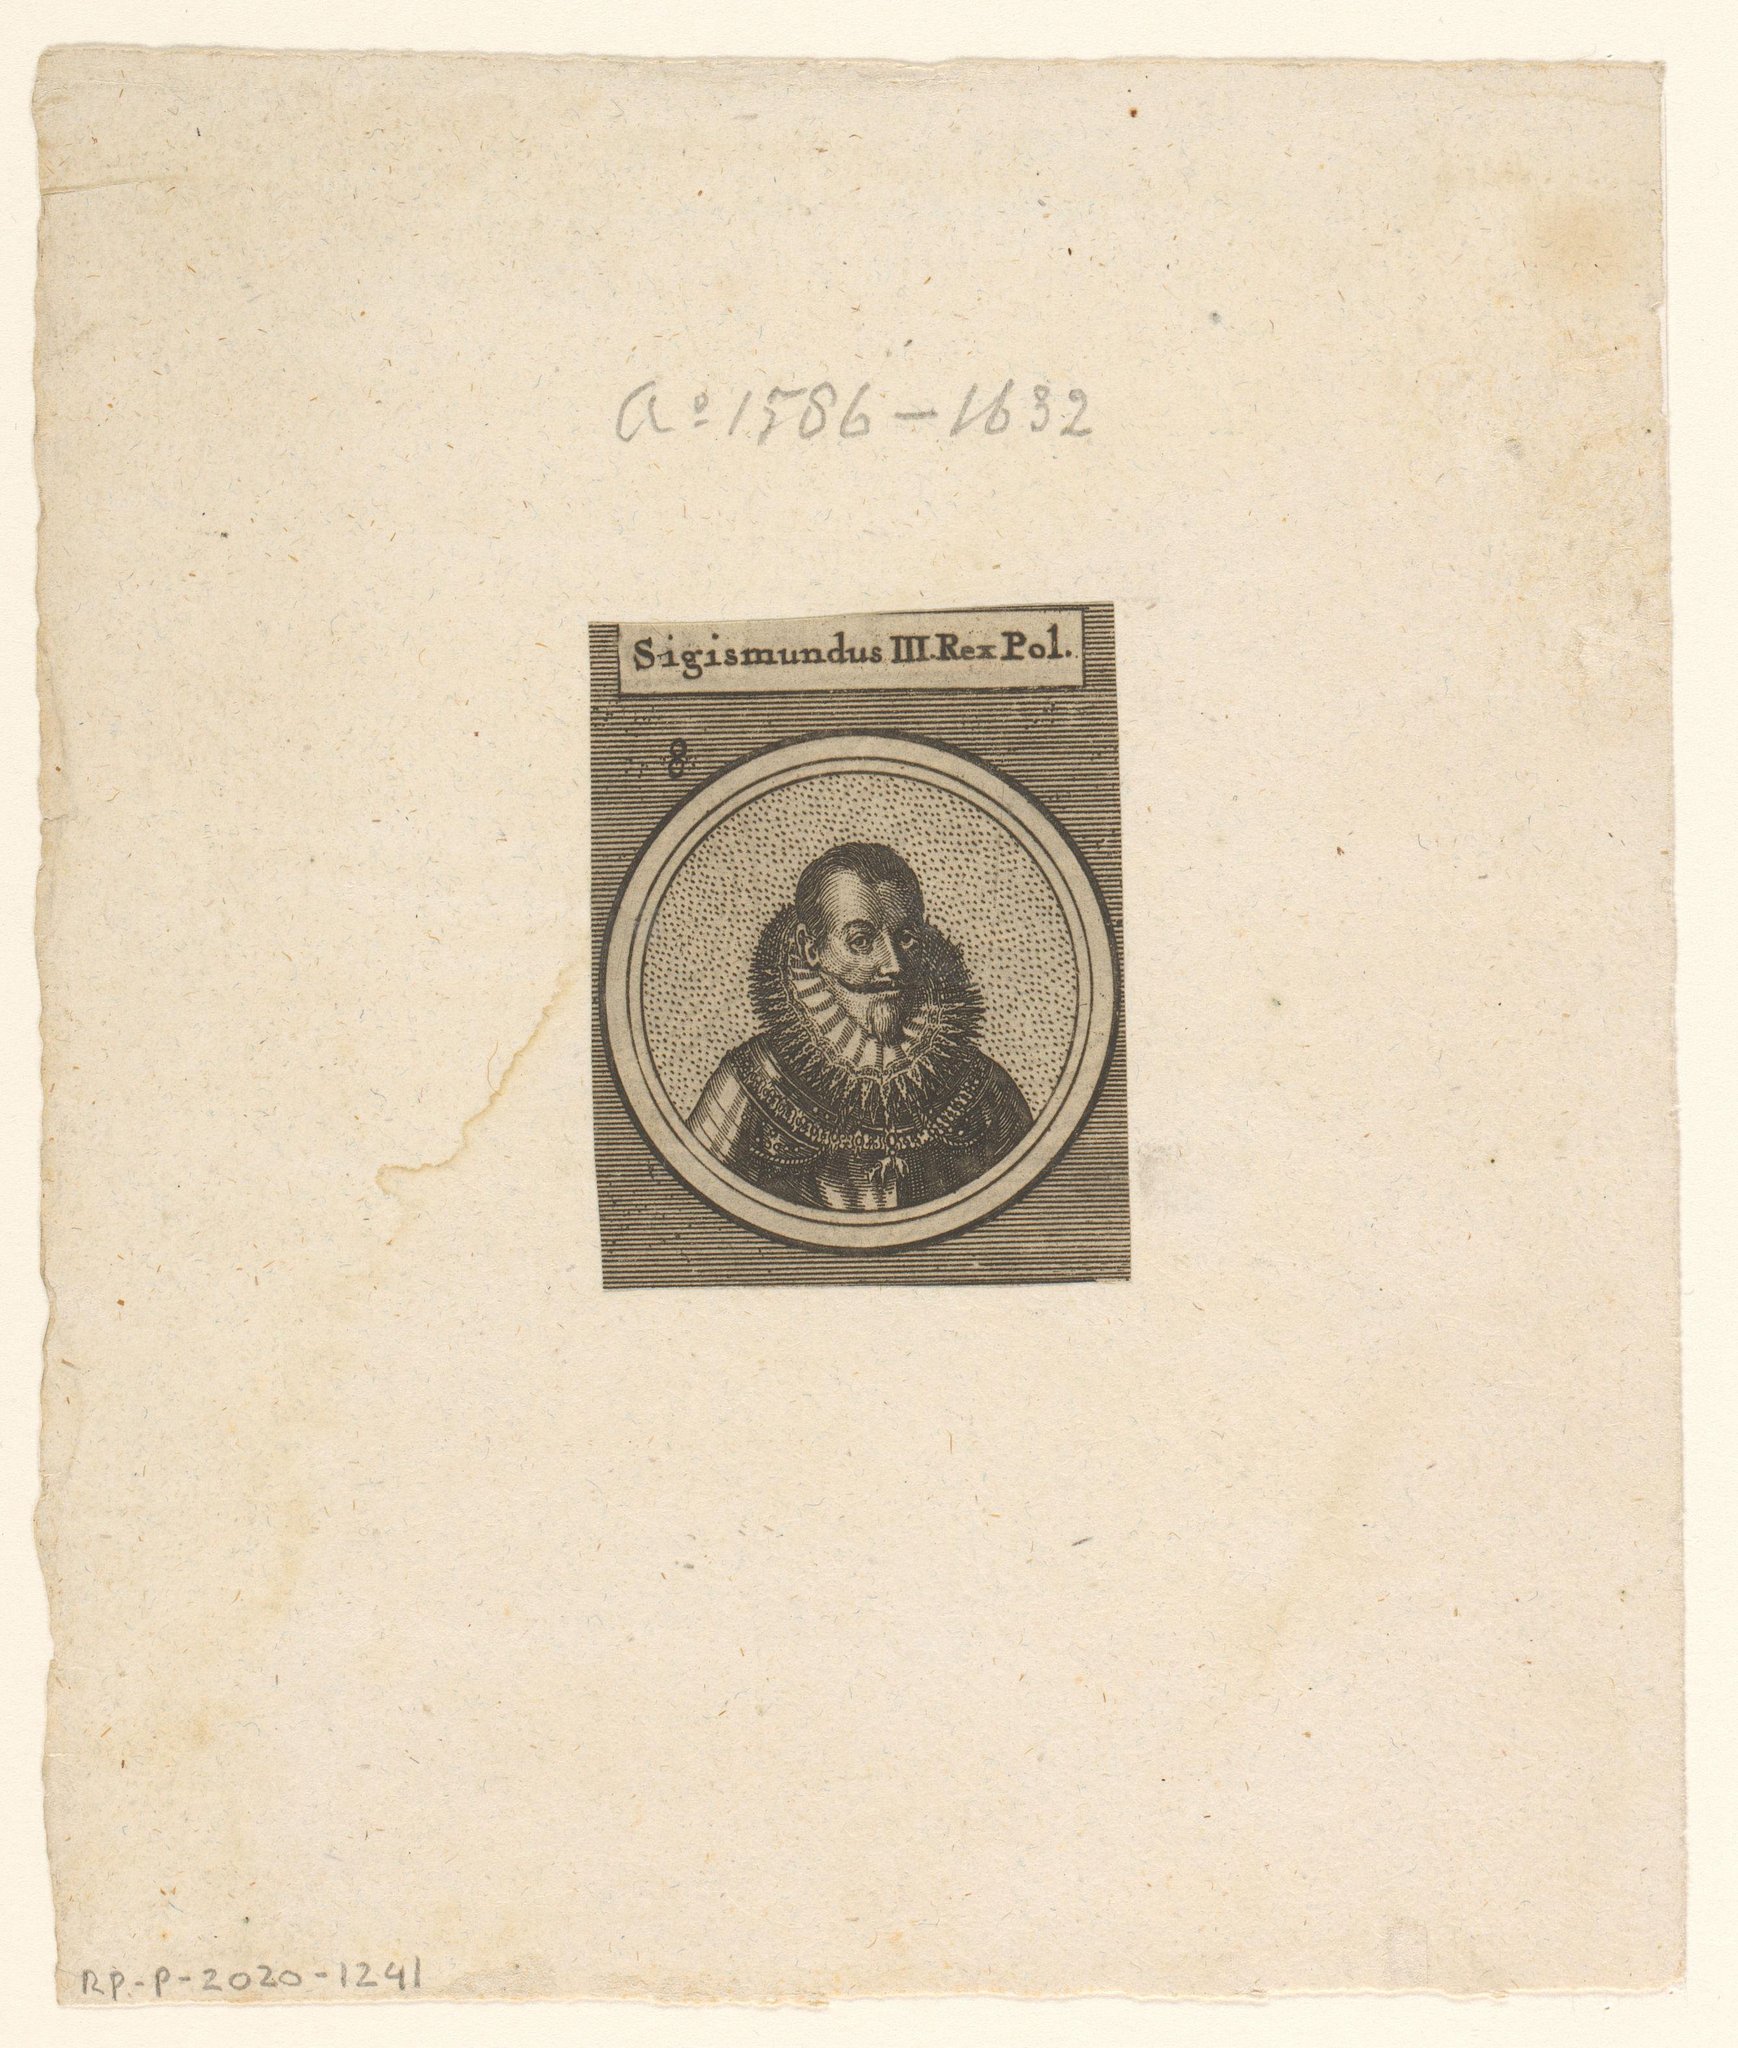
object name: print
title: Portret van Sigismund III, koning van Polen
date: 1698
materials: paper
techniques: engraving, etching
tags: sigismund iii (koning van polen), historical persons, king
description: De prent maakt onderdeel uit van een grotere prent met 12 portretten die later verknipt is. Prent gebruikt in: Gottfried, Johan Ludwig en Simon de Vries. Historische kronyck: vervattende een nauwkeurige en volkomene beschrijvingh der aldergedenck waerdiste geschiedenissen des weerelds (...). Leiden: Pieter van der Aa, 1698, dl. 1. Eerdere staat van prent voor het eerst gebruikt in hetzelfde boek uitgegeven in Amsterdam door weduwe Joannes Brouwer en Jacobus van Meurs in 1660. Prent mogelijk ook gebruikt in latere edities.